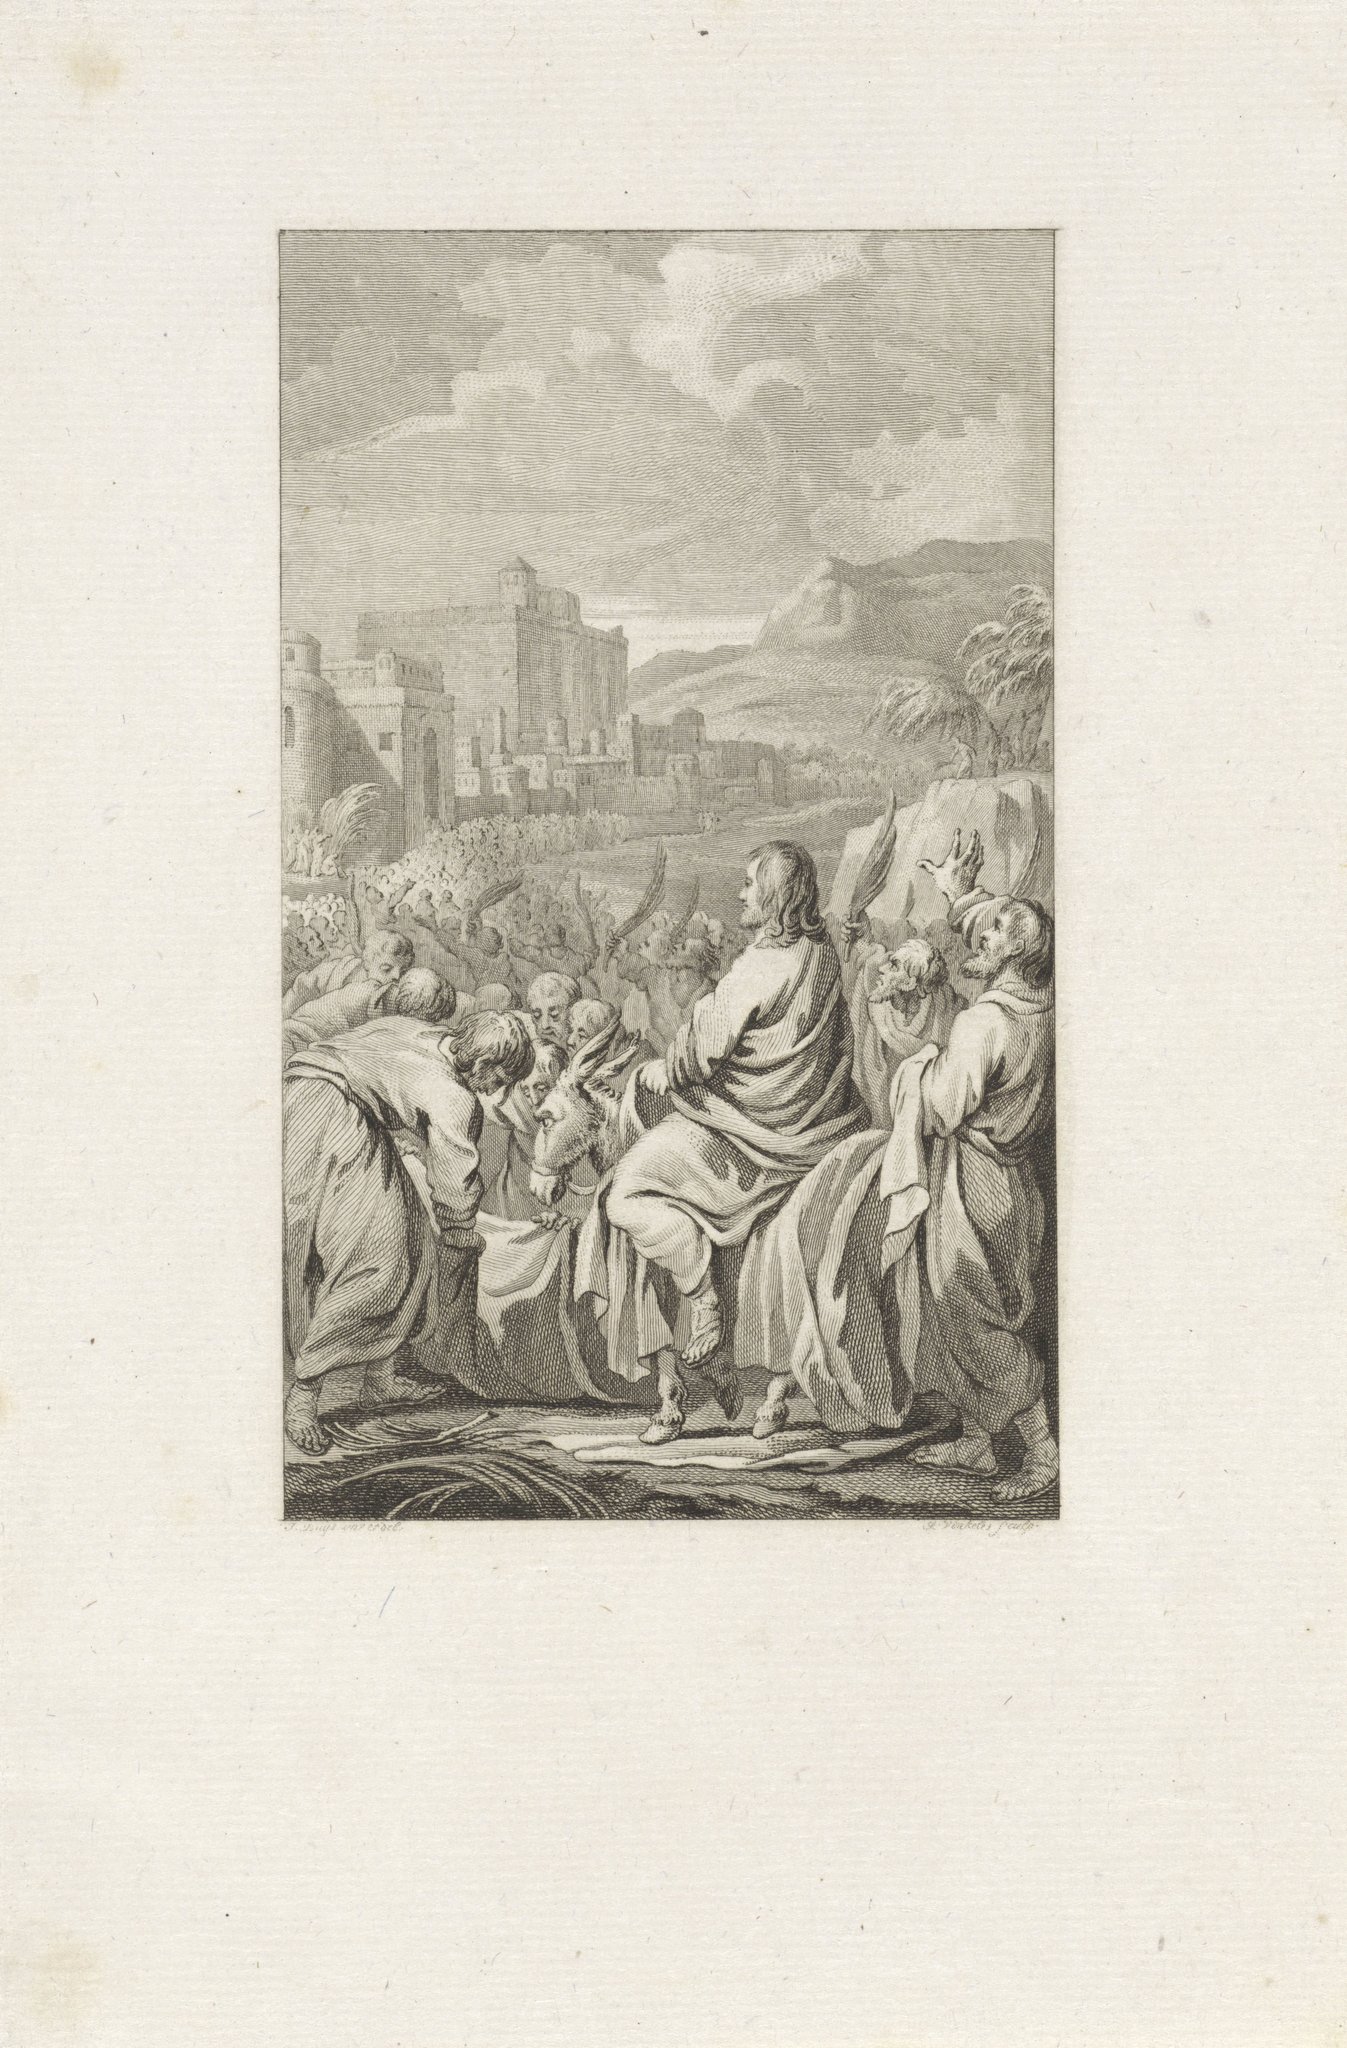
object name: print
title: Intocht in Jeruzalem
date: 1797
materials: paper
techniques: engraving, etching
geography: amsterdam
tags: entry into jerusalem: people spreading their clothes before christ on the ass, and waving palm branches (matthew 21:1-11, 21:14-16; mark 11:1-11; luke 19:28-40; john 12:12-19)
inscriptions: collector's mark: Lugt 240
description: Christus rijdt op een ezeltje Jeruzalem binnen. Mensen staan met palmtakken bij de poort en spreiden hun mantels voor Christus uit op de grond.